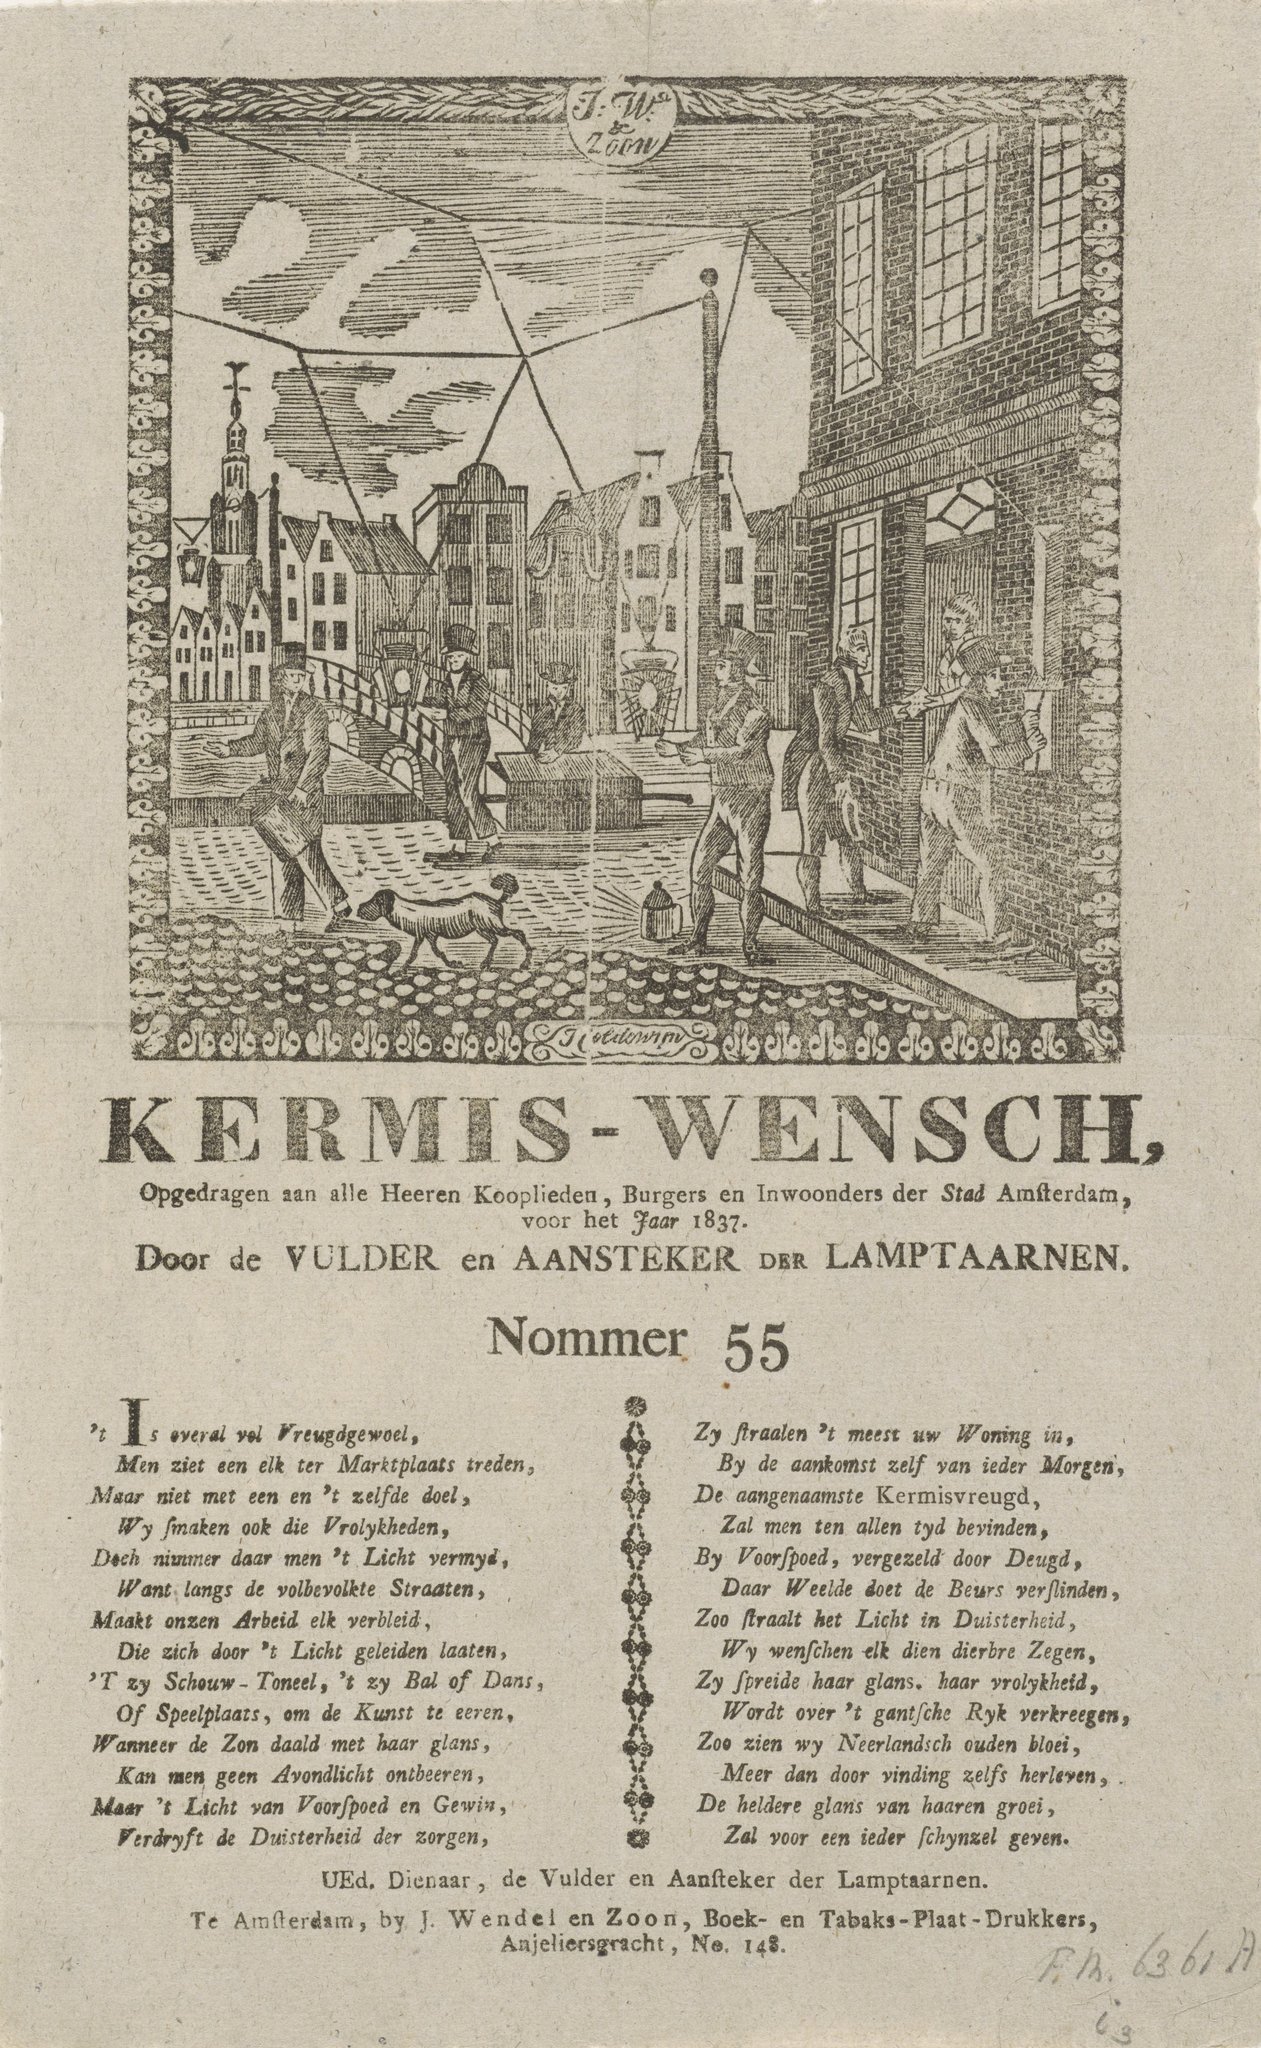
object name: print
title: Kermis-wensch (...) door de Vulder en Aansteker der Lamptaarnen. Nommer 55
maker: jacob coldewijn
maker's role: print maker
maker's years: 1796-1855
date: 1837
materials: paper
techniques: letterpress printing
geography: amsterdam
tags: oil-lamp (+ kindling a light; lit, burning light, lamp, candle), street lighting, street, amsterdam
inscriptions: collector's mark: Lugt 2228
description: Kermisprent van de Amsterdamse lantaarnopstekers en vullers voor het jaar 1837. Gezicht in een straat in Amsterdam waar enkele mannen bezig zijn de straatlantaarns te vullen en aan te steken. Een andere man haalt geld op bij een huis. Met gedicht in twee kolommen. Van de lantaarnopstekers in wijk no. 55.